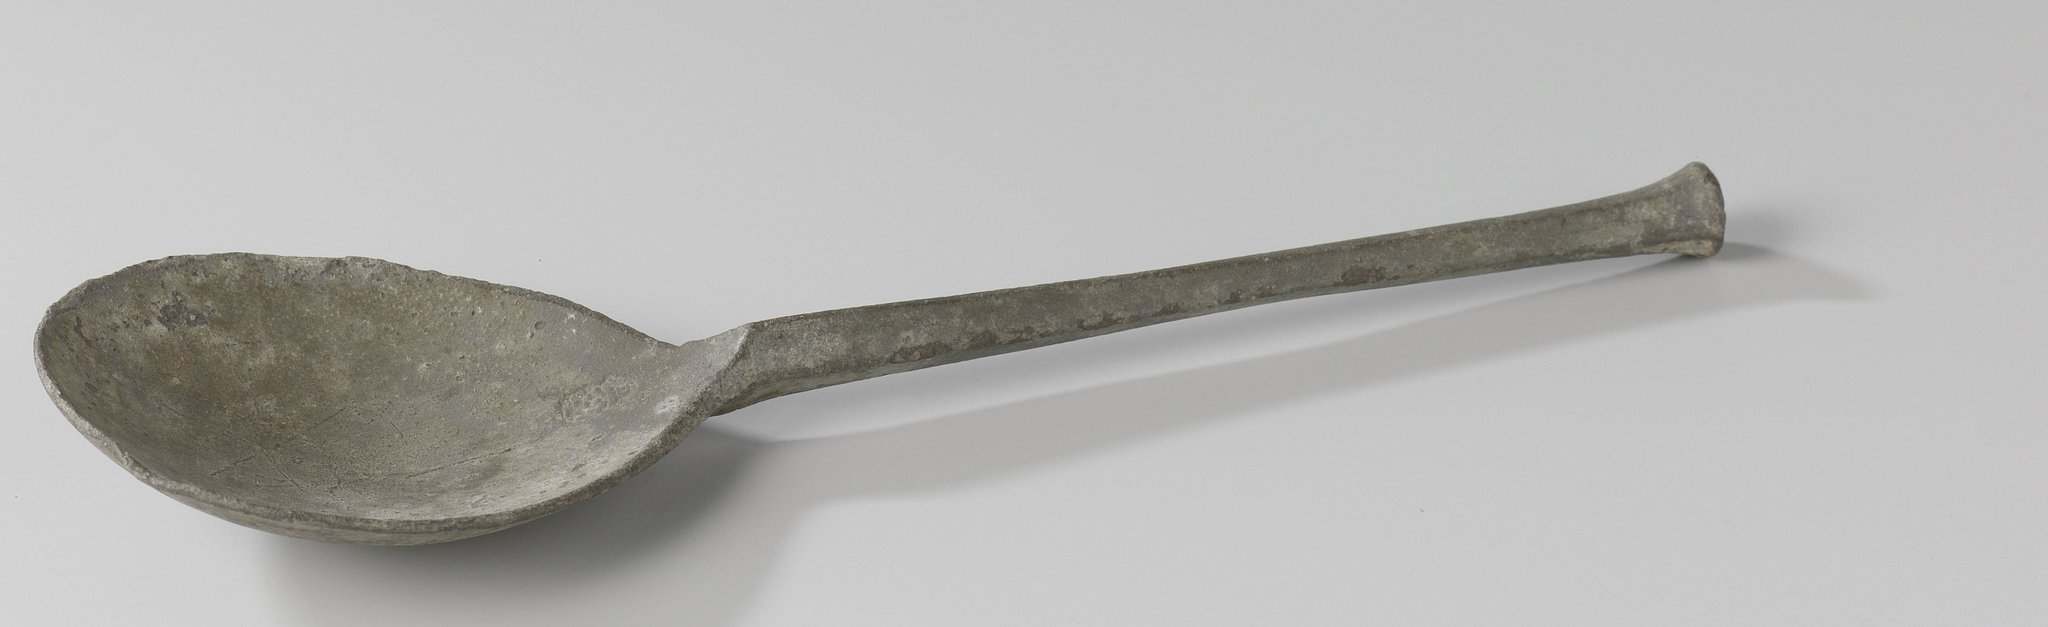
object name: spoon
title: Lepel met ovale bak en rechte steel met een ruitvormige doorsnede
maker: Anonymous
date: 1590-1596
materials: tin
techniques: casting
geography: netherlands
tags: willem barendsz., amsterdam, jacob van heemskerck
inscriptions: mark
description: Pewter/Tin spoon